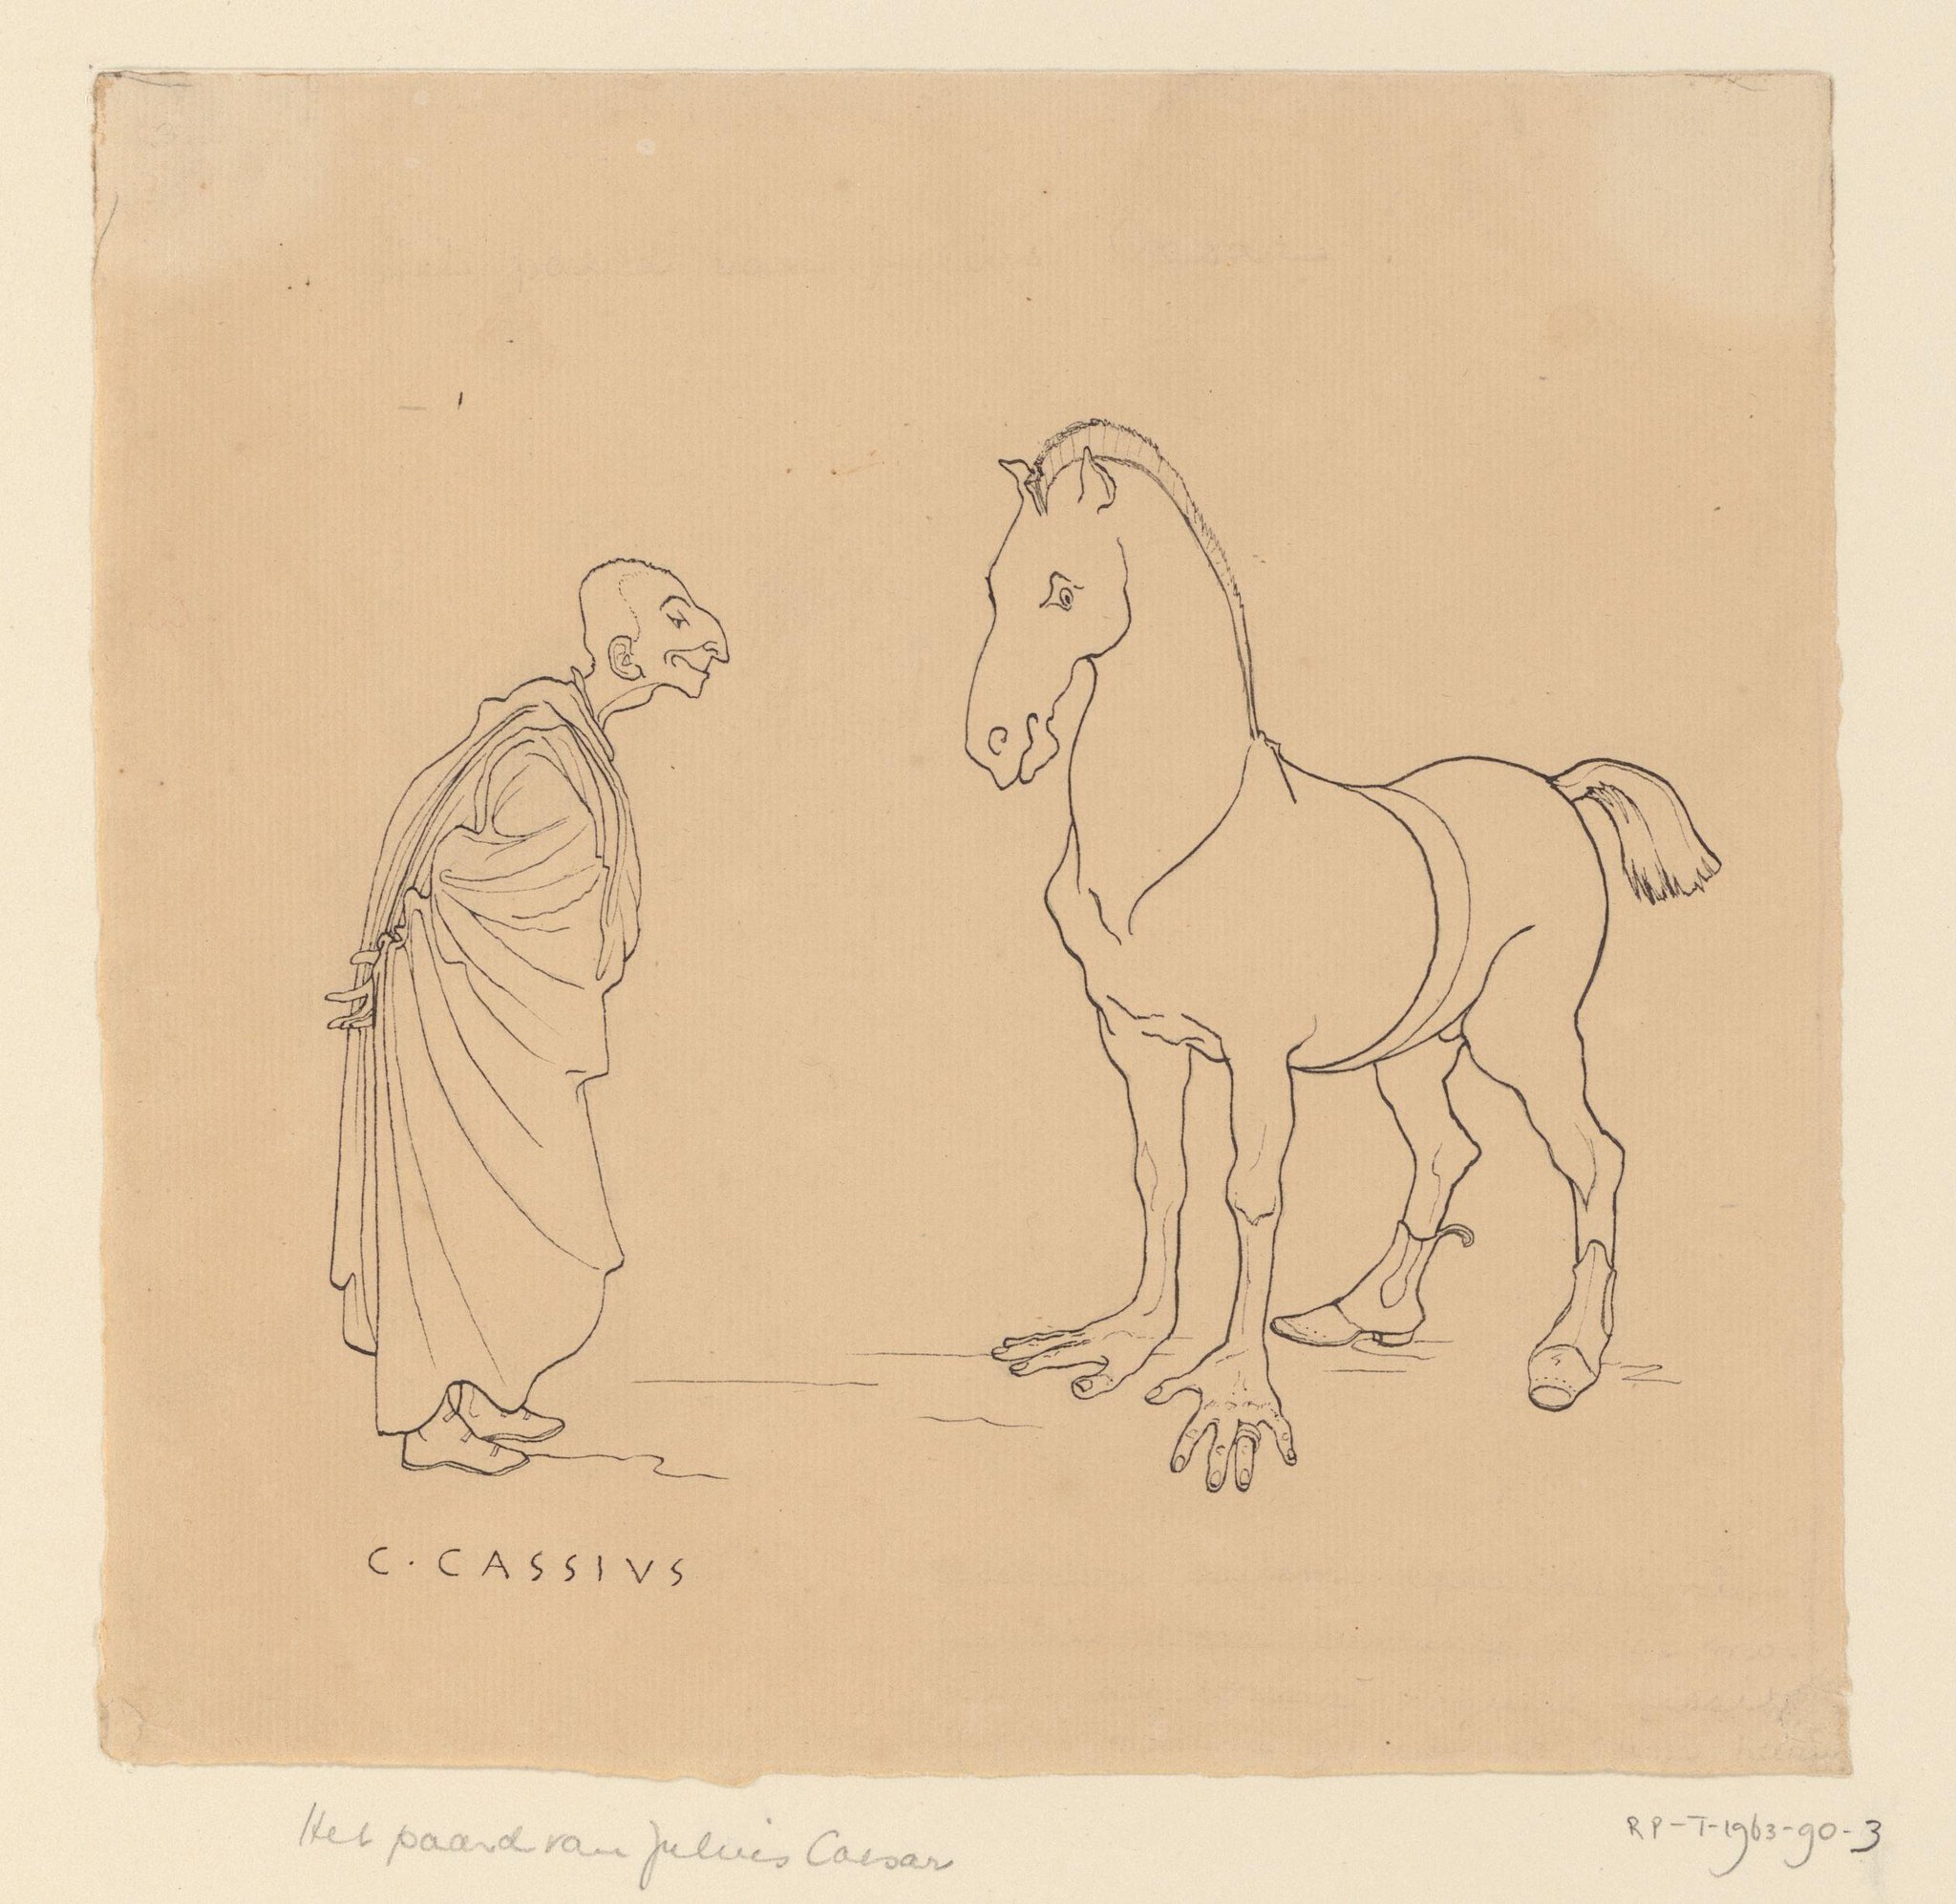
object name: drawing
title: Het paard van Julius Caesar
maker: johan huizinga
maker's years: 1872-1945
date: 1893-1895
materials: ink, paper, pencil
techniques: pen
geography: netherlands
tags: (story of) c. julius caesar, horse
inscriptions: collector's mark: Lugt 2228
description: Julius Caesar met zijn paard dat handen als voorpoten heeft en schoenen draagt op de achterpoten, ca. 60 v. Chr. Onderdeel van de map met 18 tekeningen gereproduceerd in Johan Huizinga's 'Keur van gedenkwaardige tafereelen uit de vaderlandsche historiën' uit 1950.